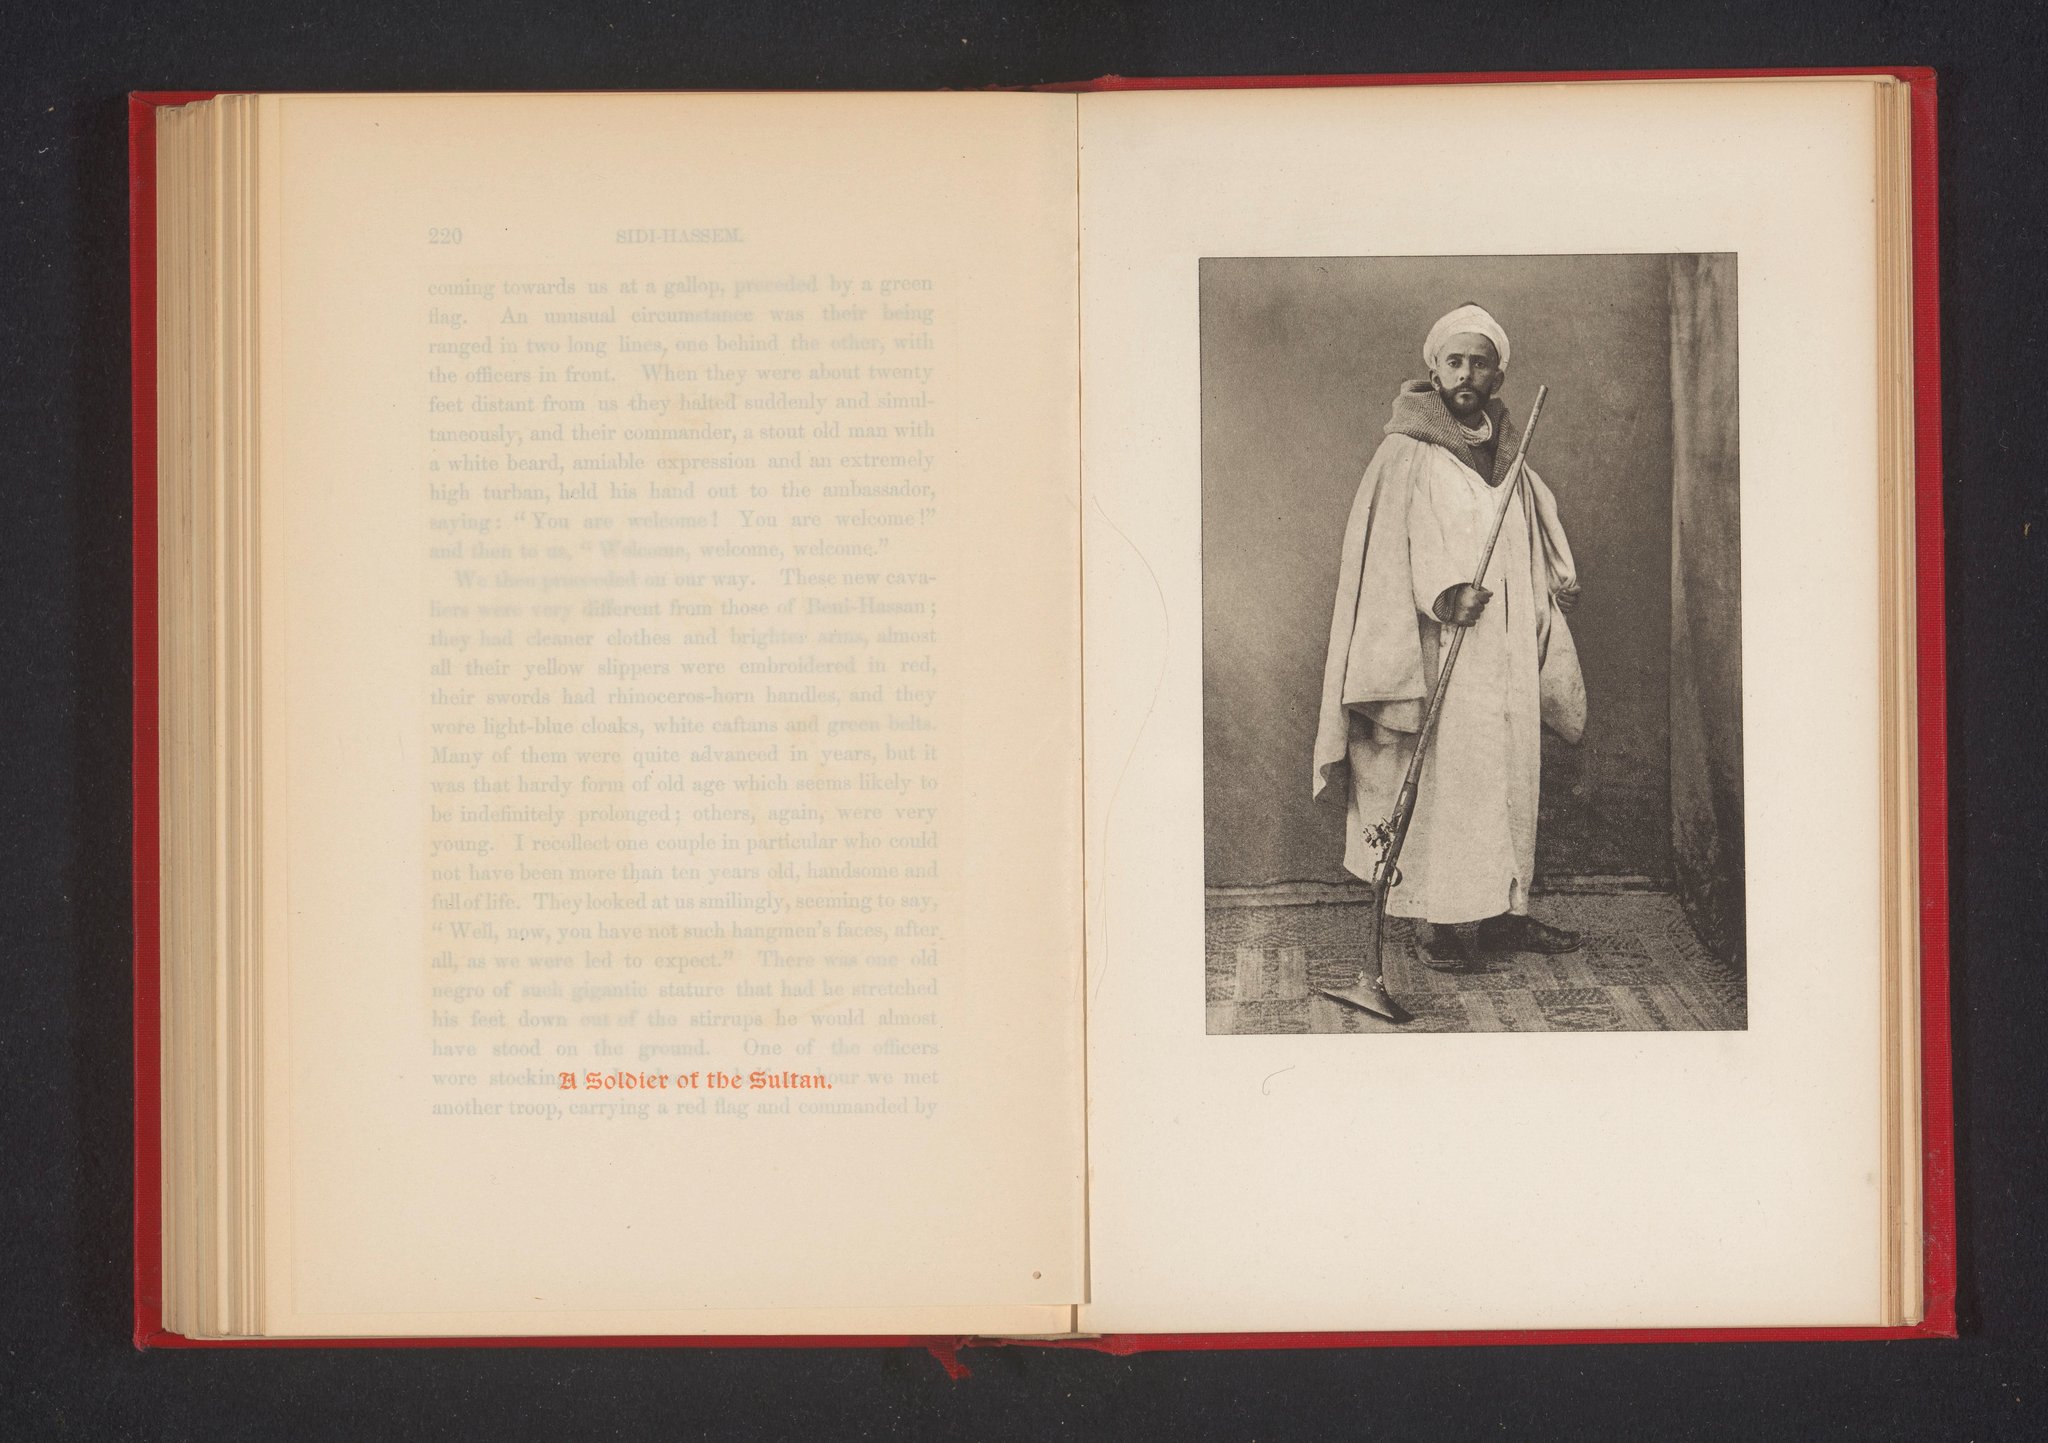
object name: page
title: Portret van een soldaat met een geweer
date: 1887-1897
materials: paper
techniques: photoaquatint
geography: morocco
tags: private soldier, firearms: rifle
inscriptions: title: ‘A Soldier of the Sultan.’